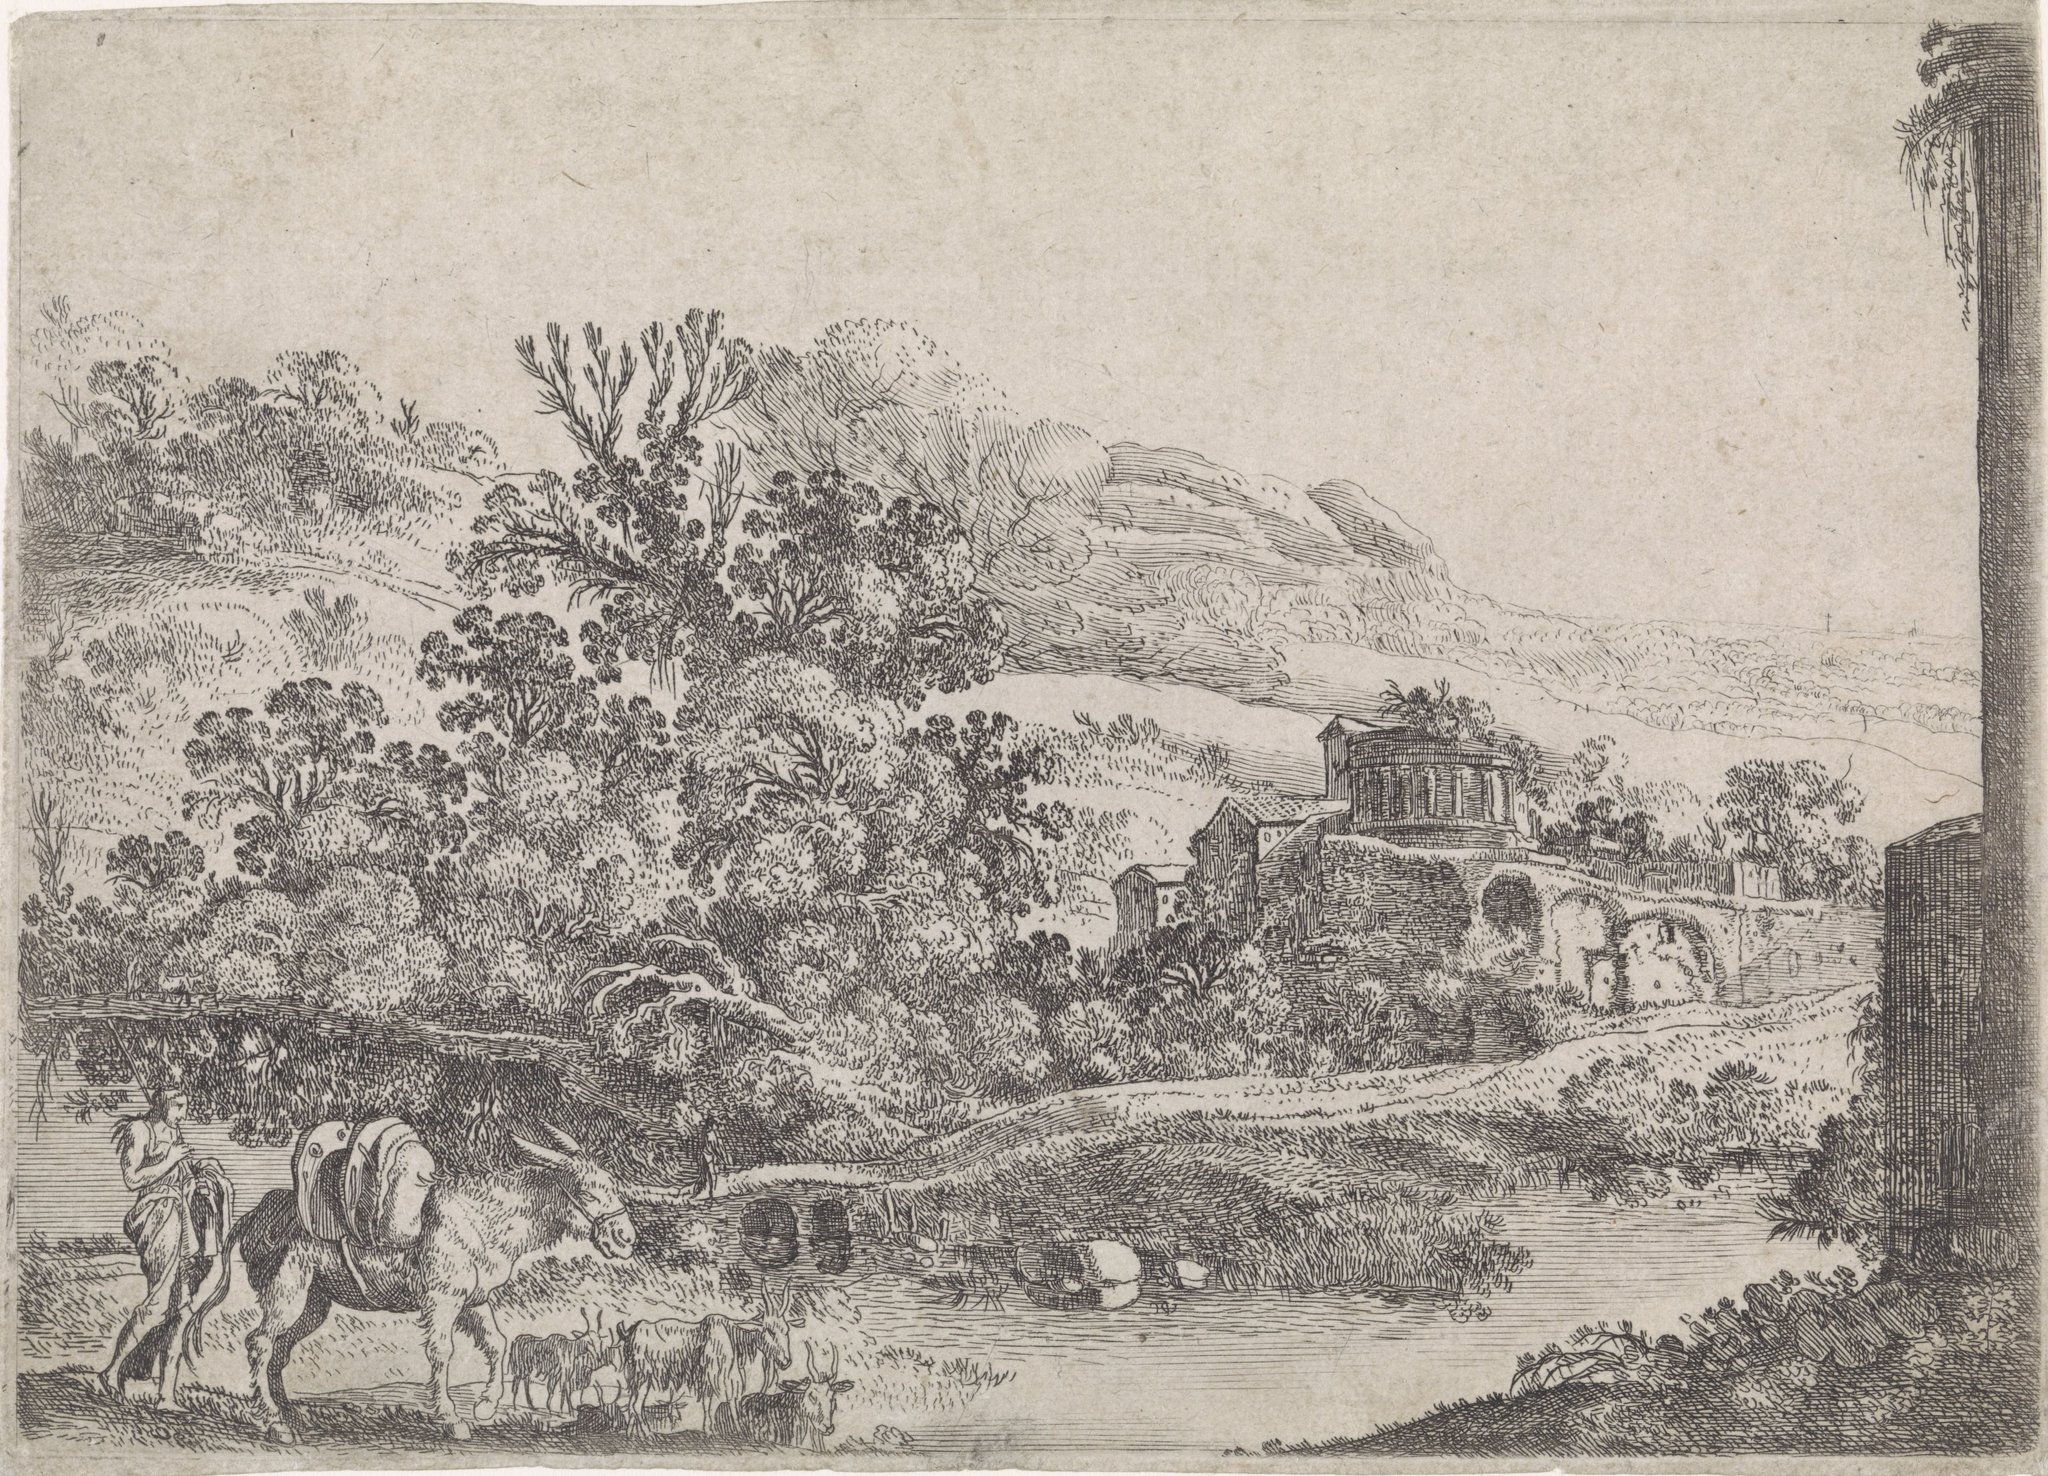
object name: print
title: Landschap met beladen ezel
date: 1633-1644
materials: paper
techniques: etching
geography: amsterdam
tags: animal mounts; pack-animals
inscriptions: collector's mark: Lugt 2228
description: Een vrouw loopt met een bepakte ezel en een groep geiten langs een vijver in een heuvellandschap met enkele gebouwen in klassieke stijl.